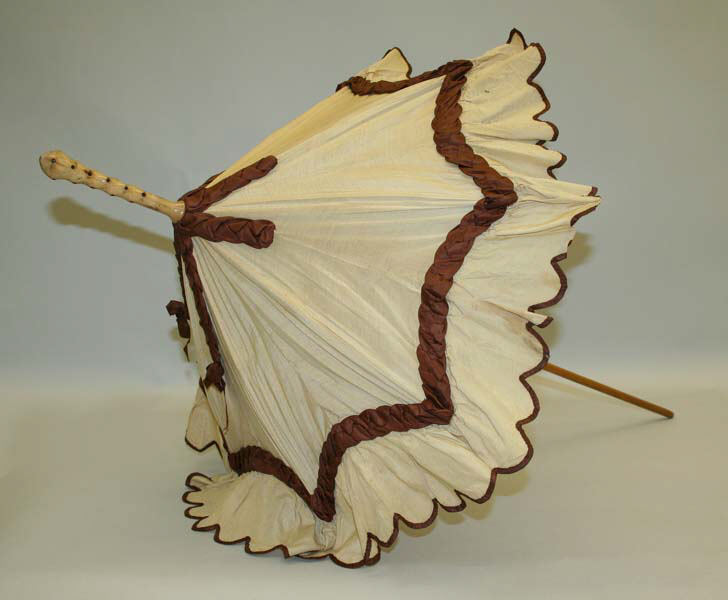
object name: parasol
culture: american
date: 1870-1879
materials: silk, wood